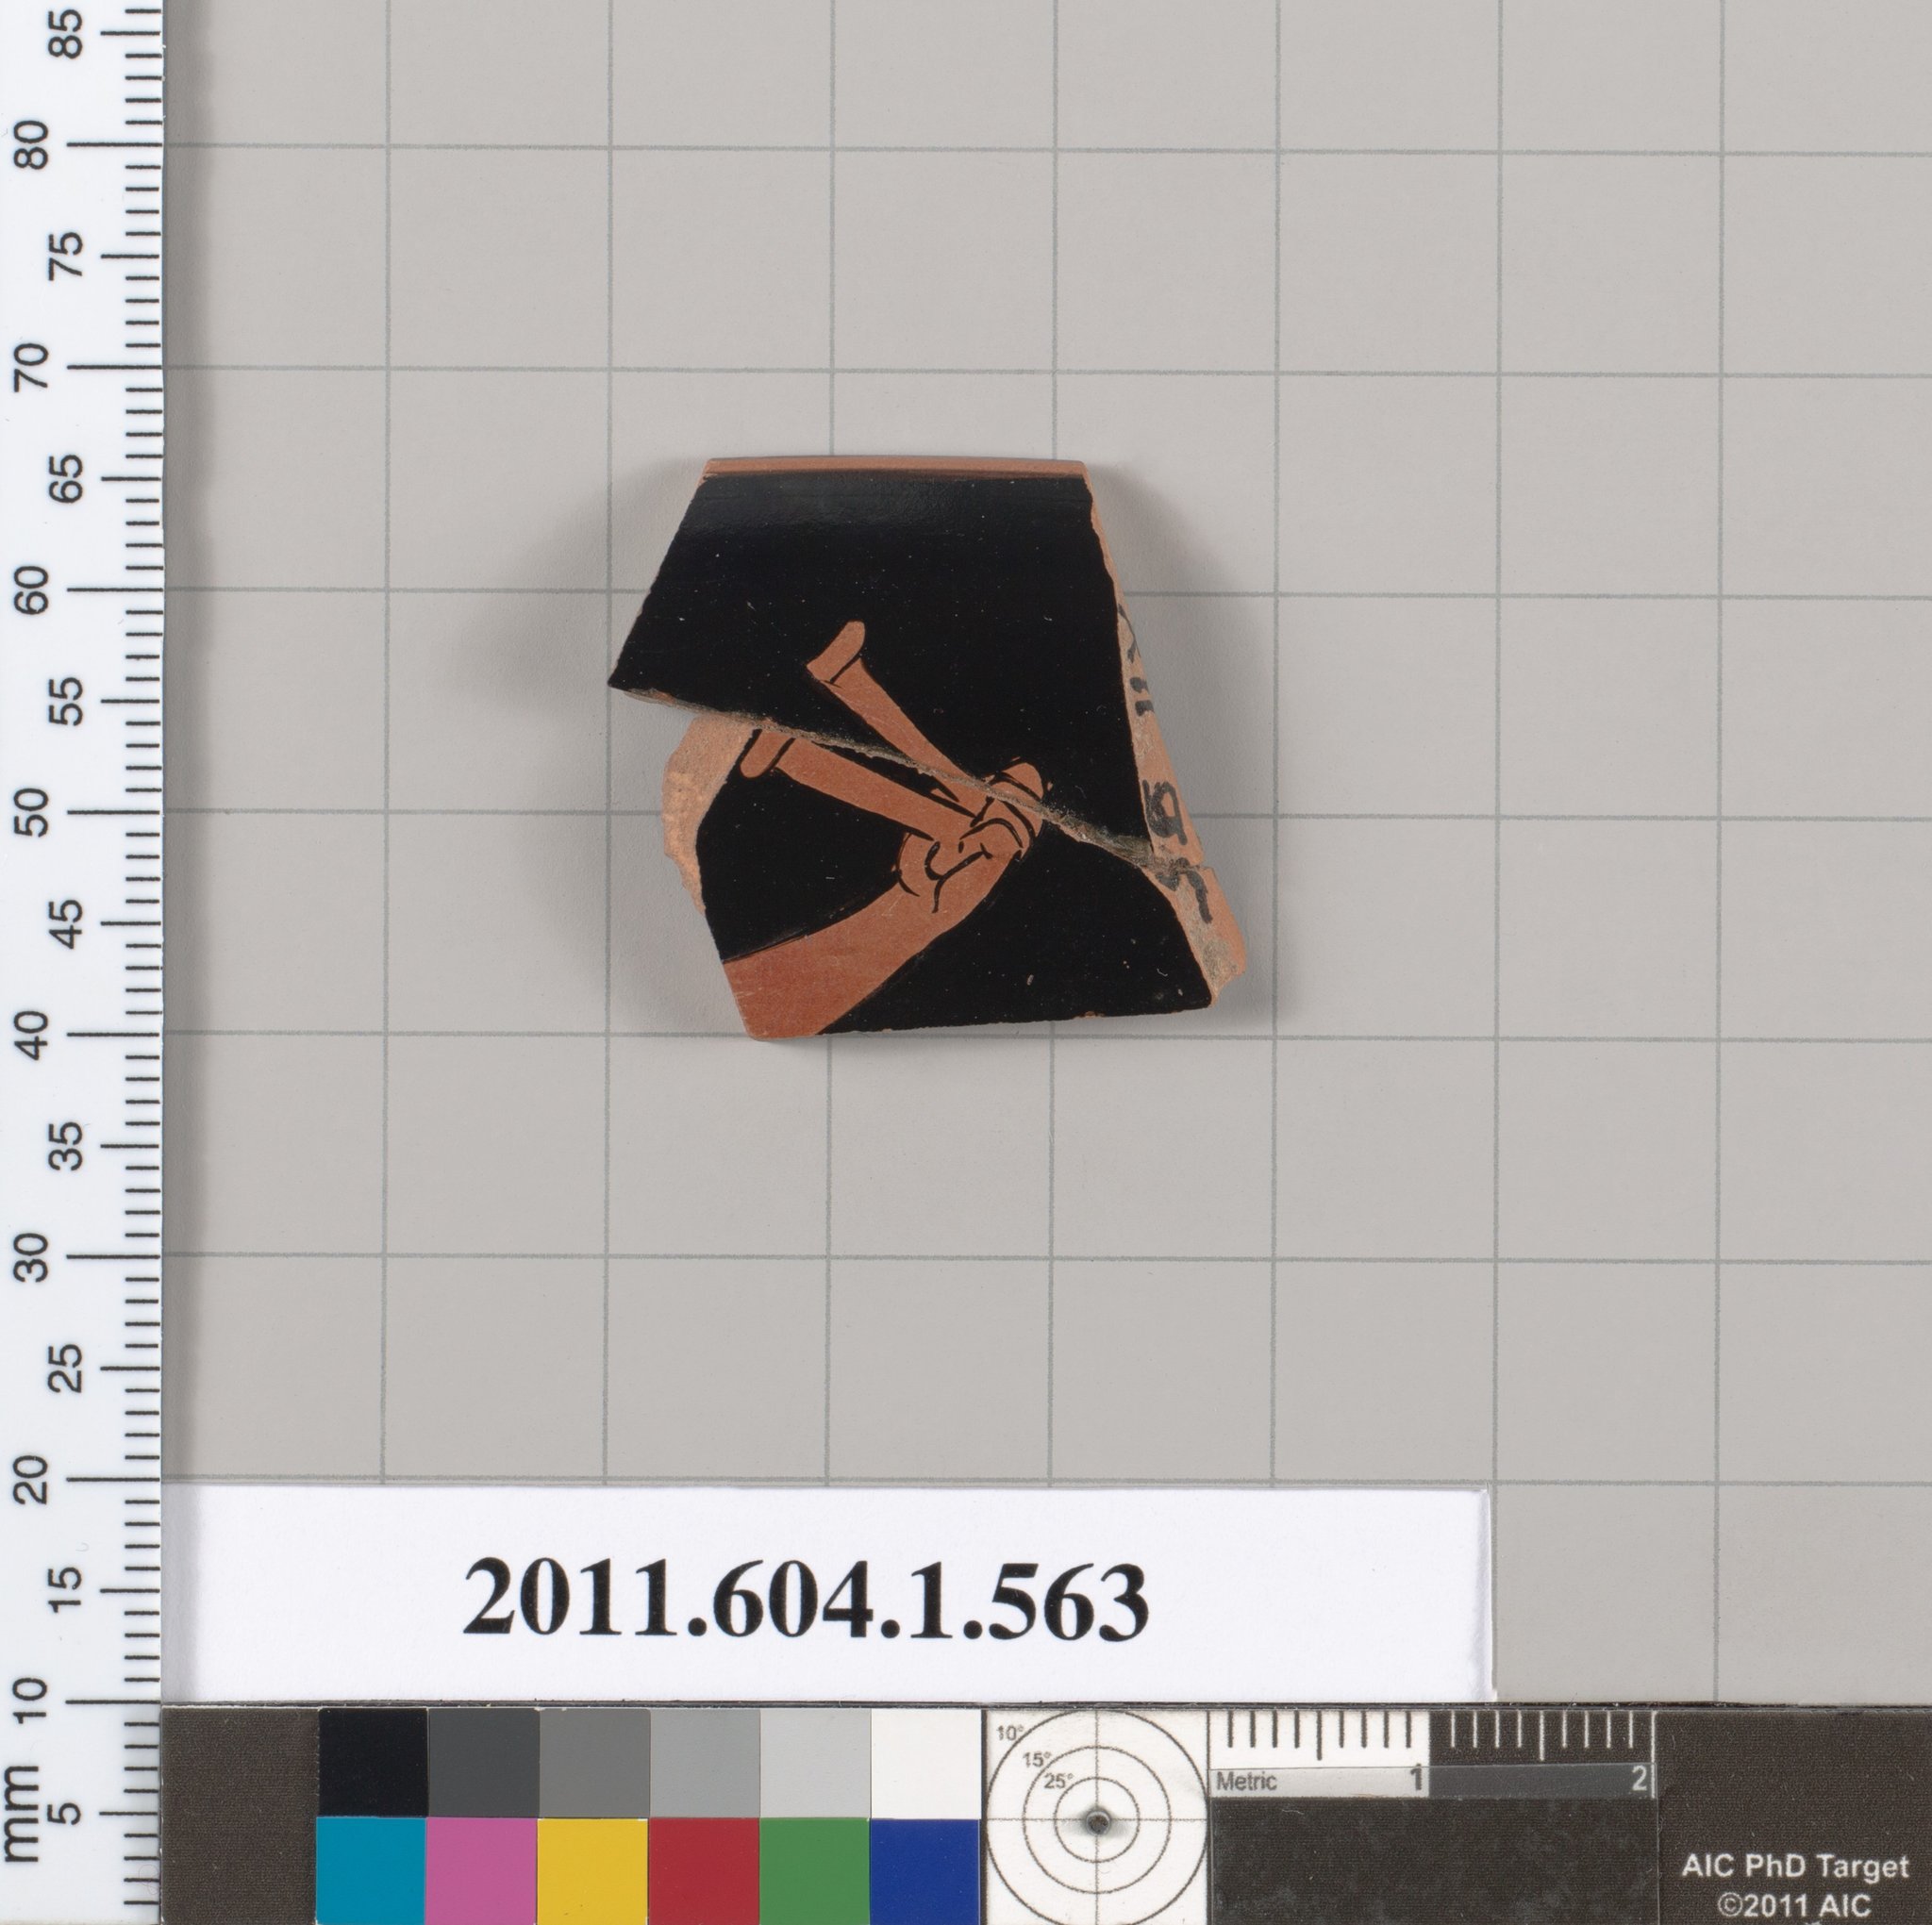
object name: kylix fragment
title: Terracotta rim fragment of a kylix (drinking cup)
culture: greek, attic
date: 480-470 BCE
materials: terracotta